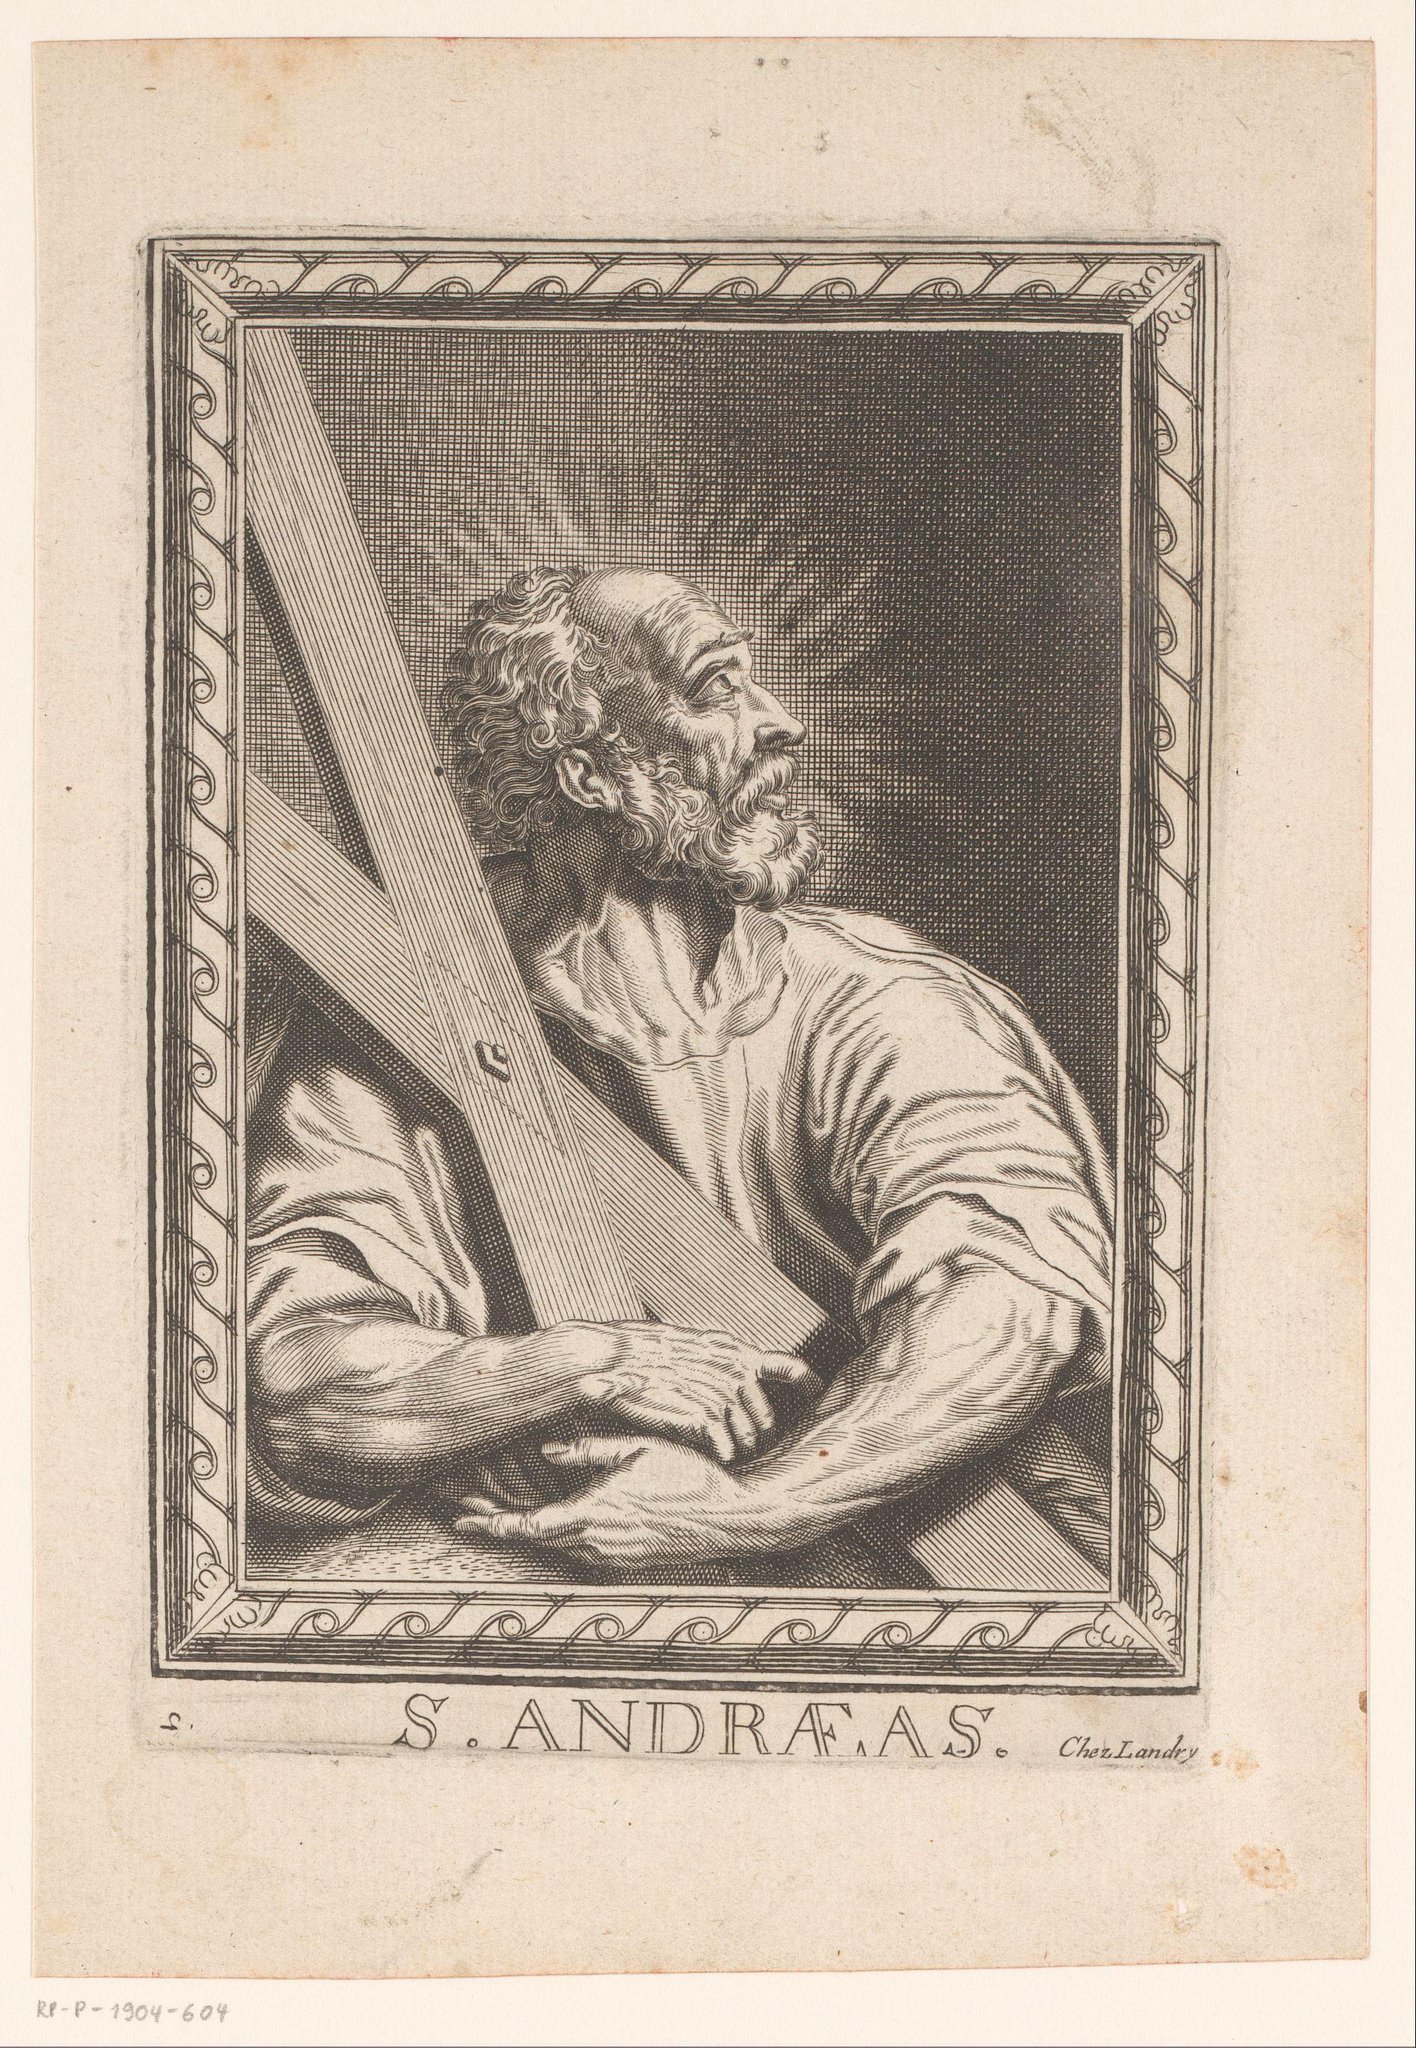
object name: print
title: H. Andreas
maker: pierre landry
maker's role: print maker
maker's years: 1630-1701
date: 1640-1701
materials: paper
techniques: engraving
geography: paris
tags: the apostle andrew; possible attributes: book, x-shaped cross, fish, fishing-net, rope, scroll - portrait of male saint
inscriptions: collector's mark: Lugt 2228